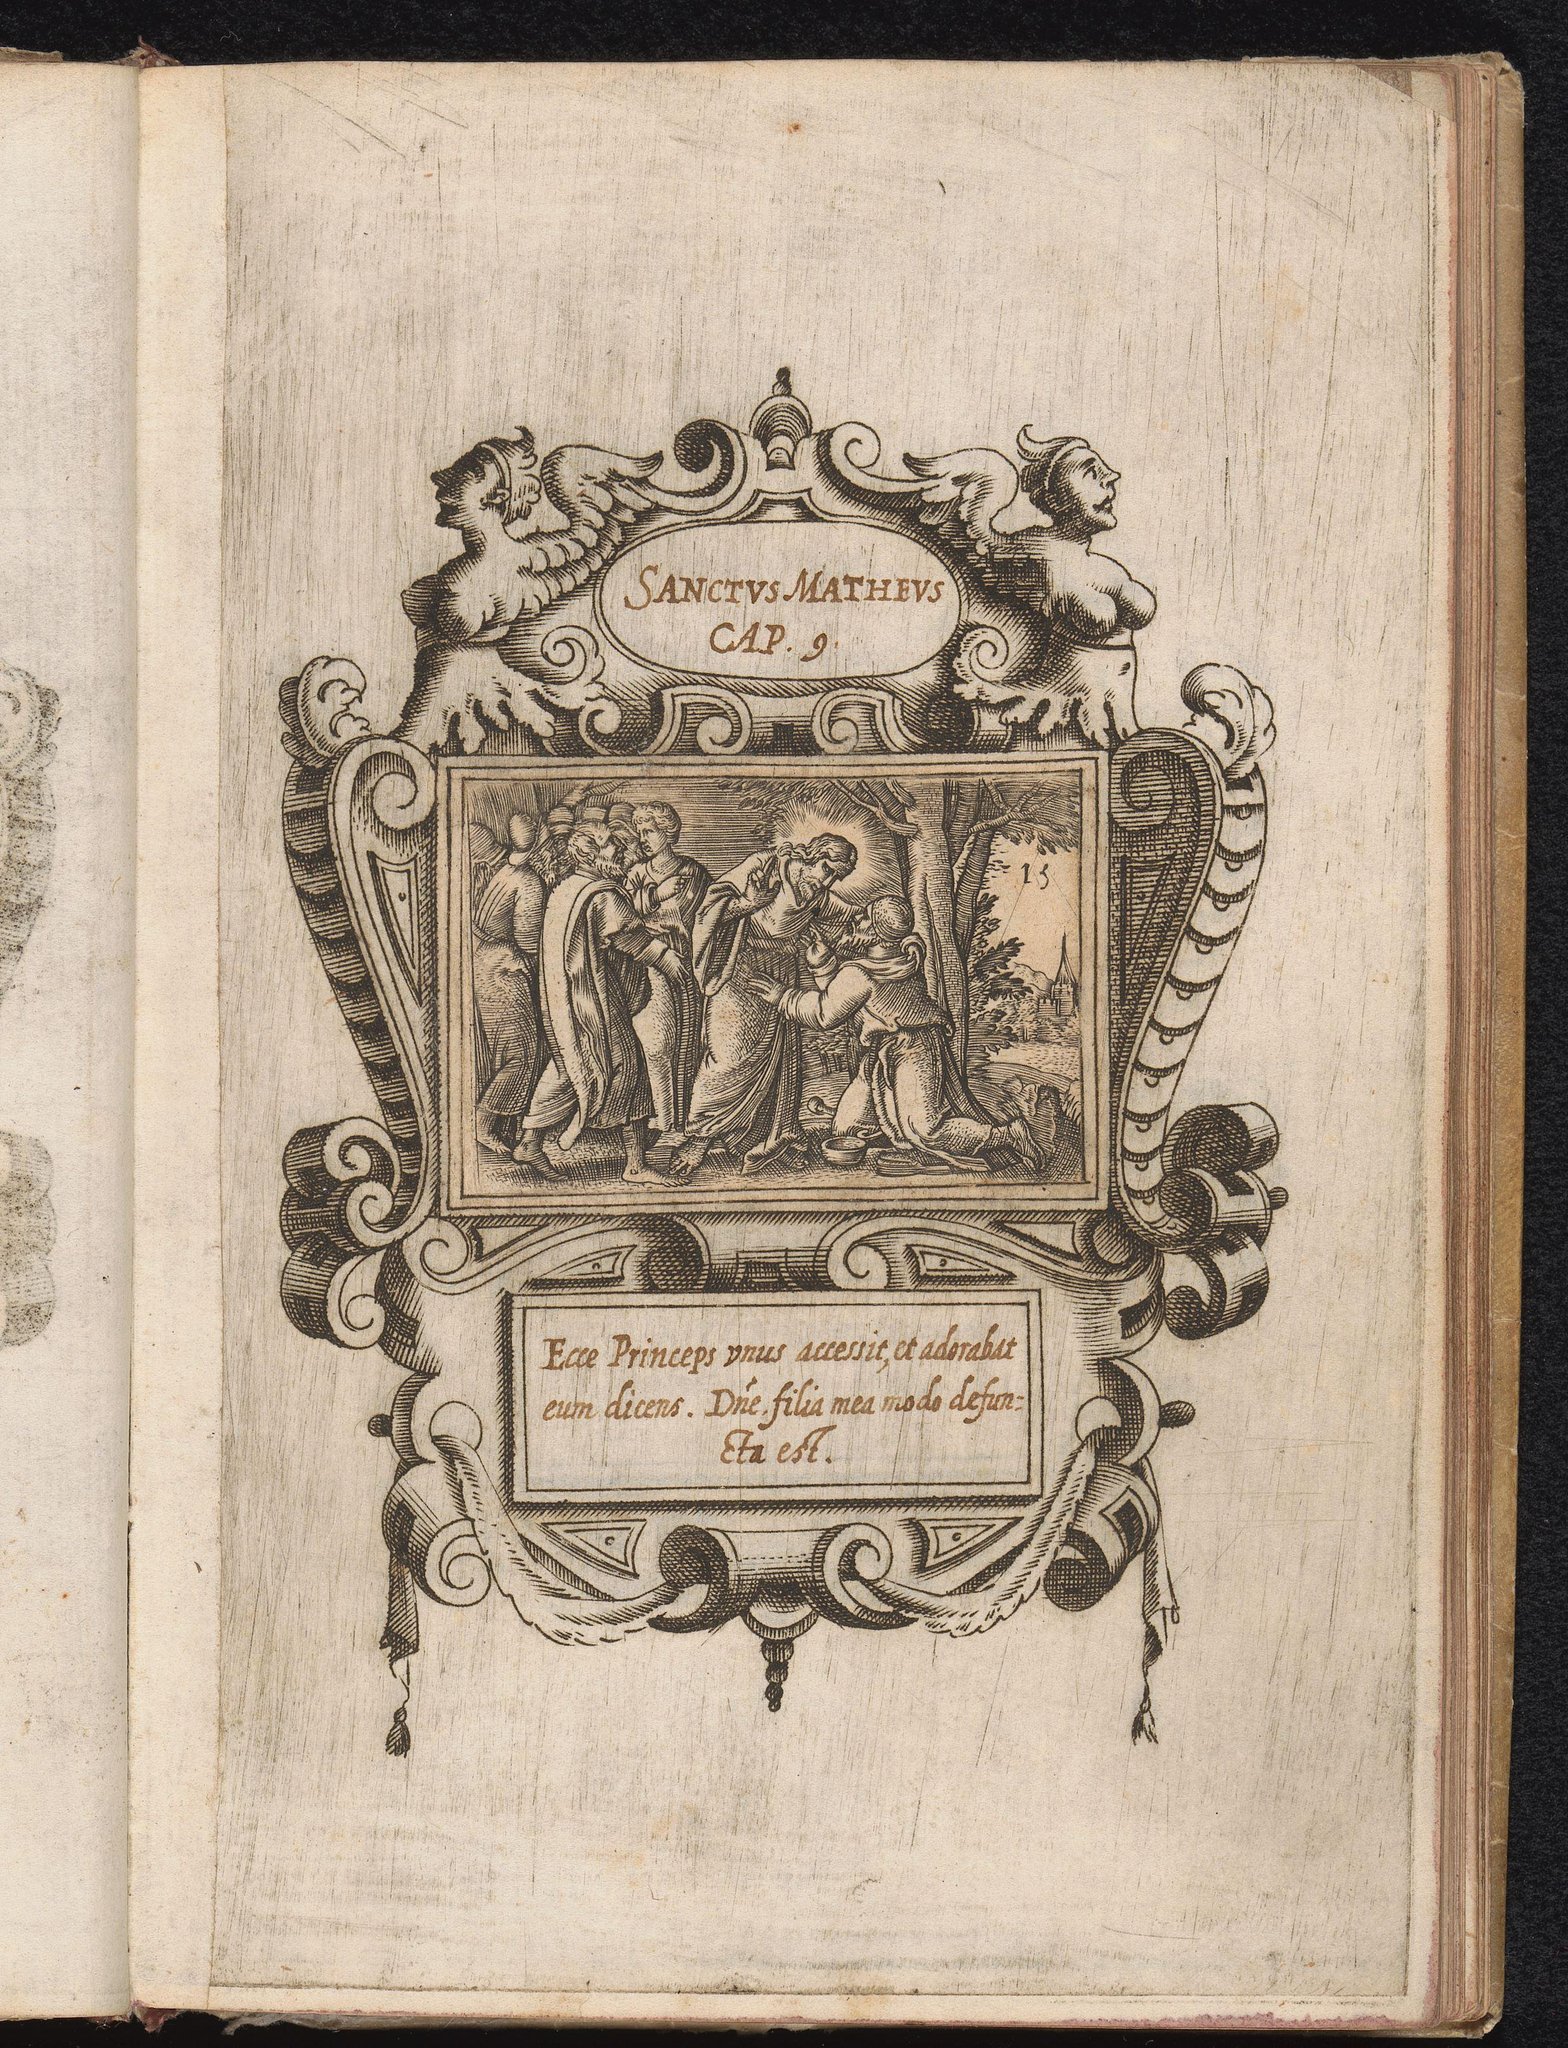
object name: print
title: Christus geneest de melaatse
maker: Anonymous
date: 1570-1610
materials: paper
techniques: engraving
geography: antwerp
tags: healing of one leper, who kneels before christ (matthew 8:1-4; mark 1:40-45; luke 5:12-16)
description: Christus geneest de melaatse. Onderdeel van een prentalbum met titelprent en 56 scènes uit het Nieuwe Testament. Elke voorstelling gemonteerd in een gravure met ornamentele cartouches waarin een venster is gesneden en voorzien van handgeschreven bijbelpassages.